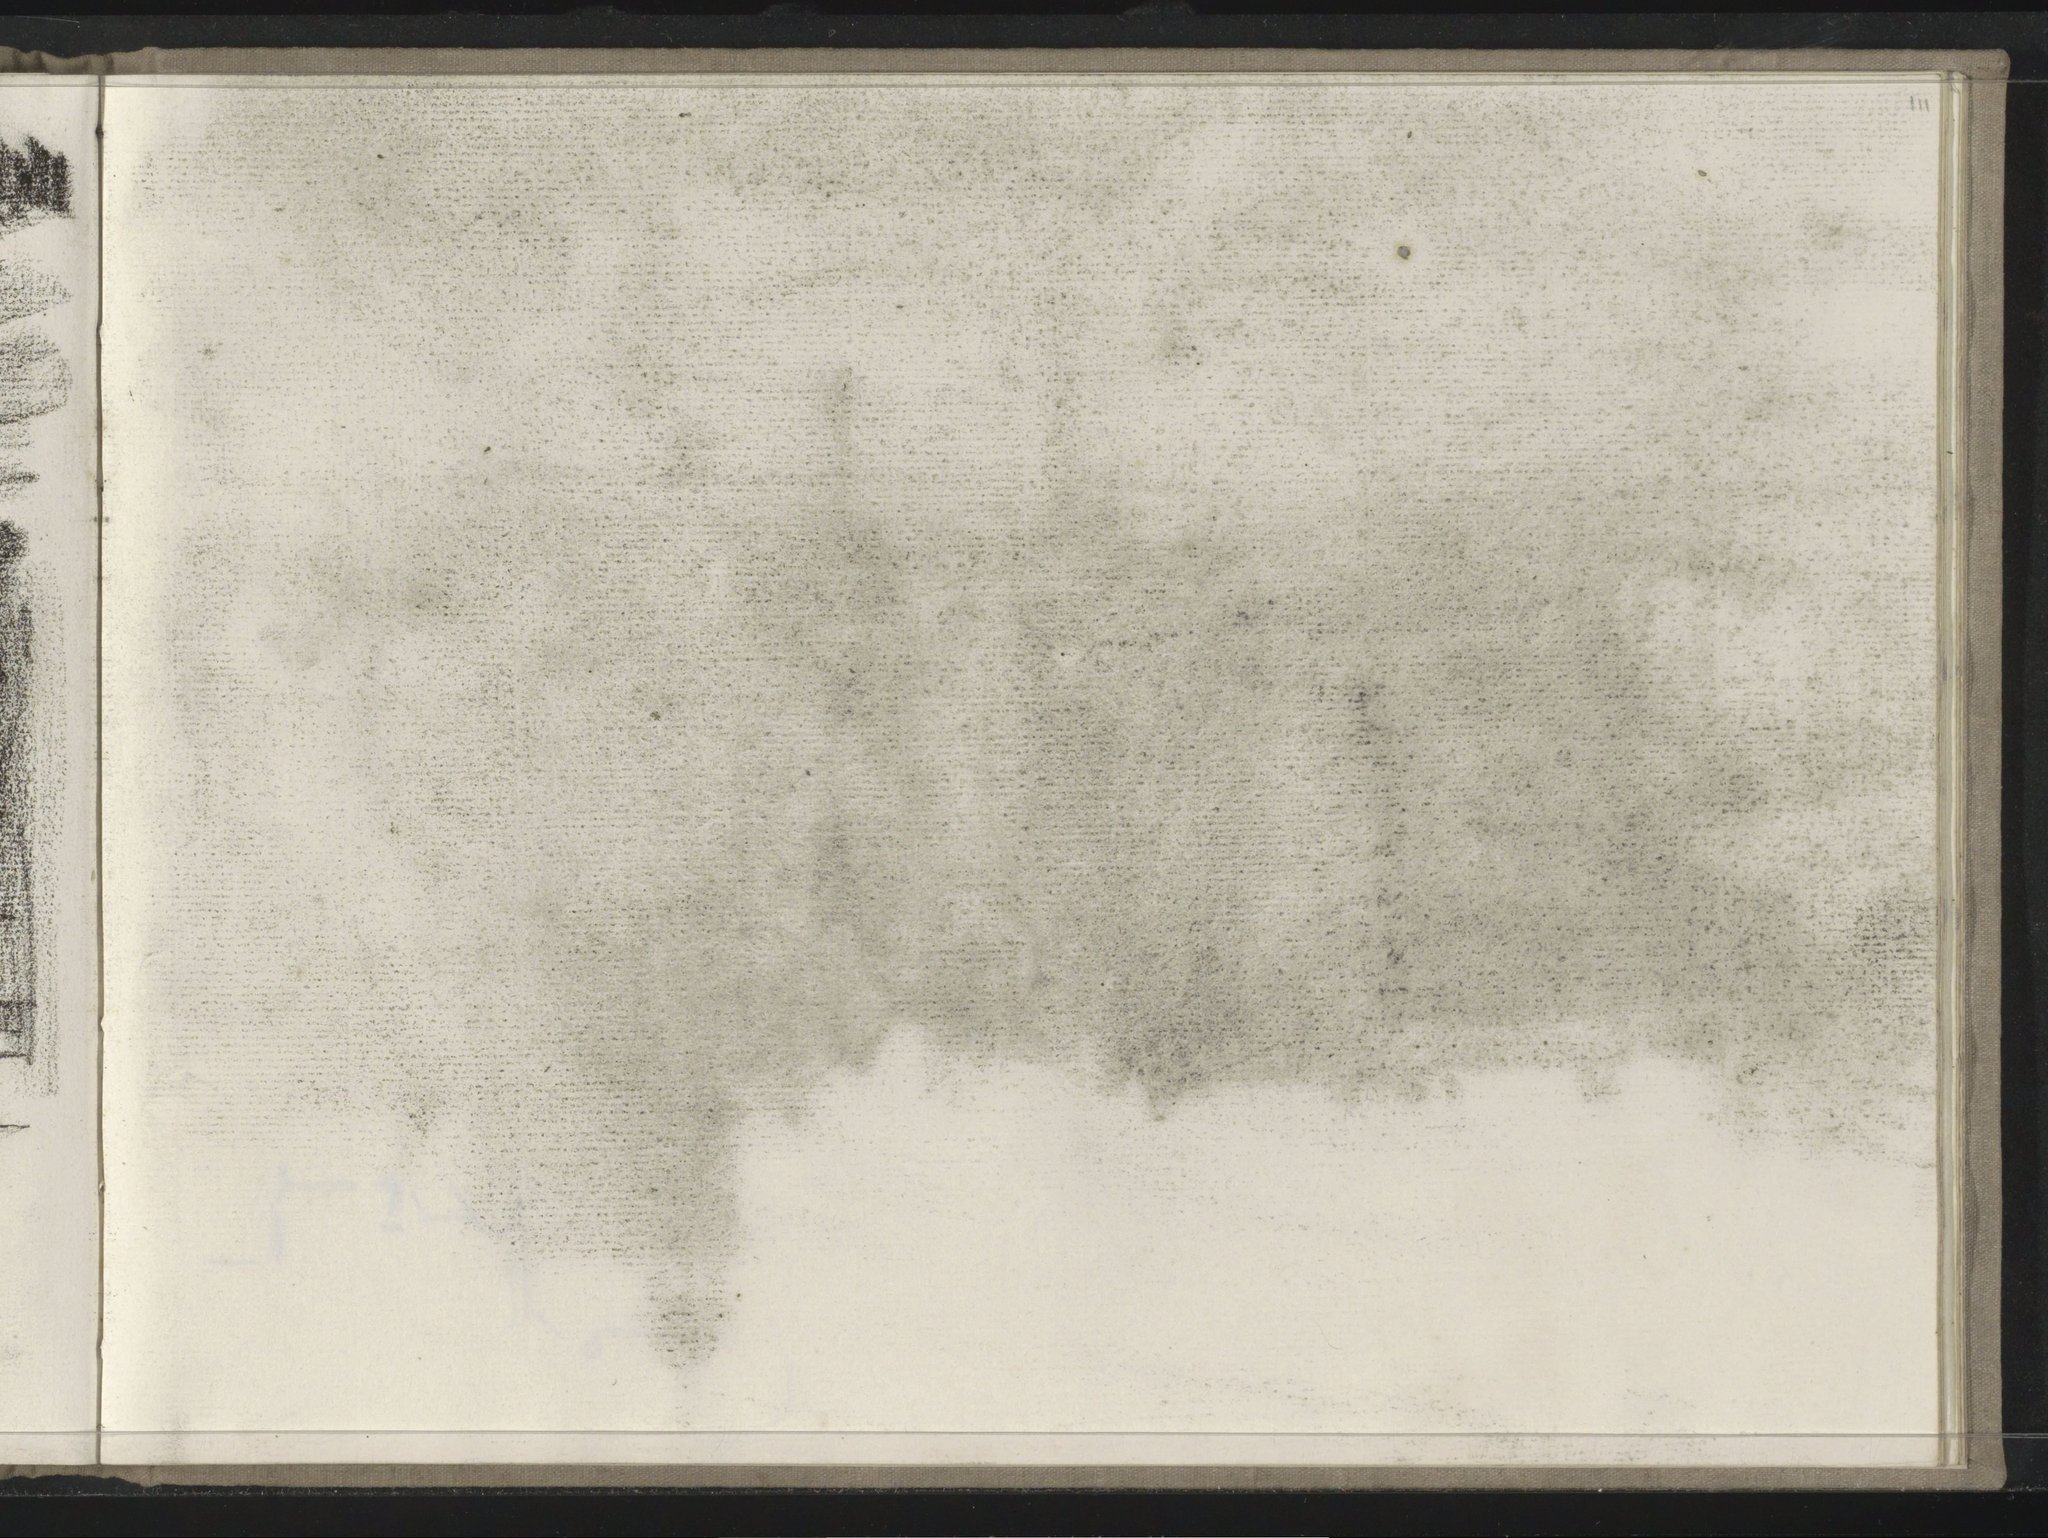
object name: sketchbook leaf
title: Abklatsch van de krijttekening op pagina 110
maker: willem witsen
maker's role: draughtsman, painter, print maker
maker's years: 1860-1923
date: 1888-1907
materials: paper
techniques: printmaking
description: Pagina 111 uit een schetsboek met 72 bladen.